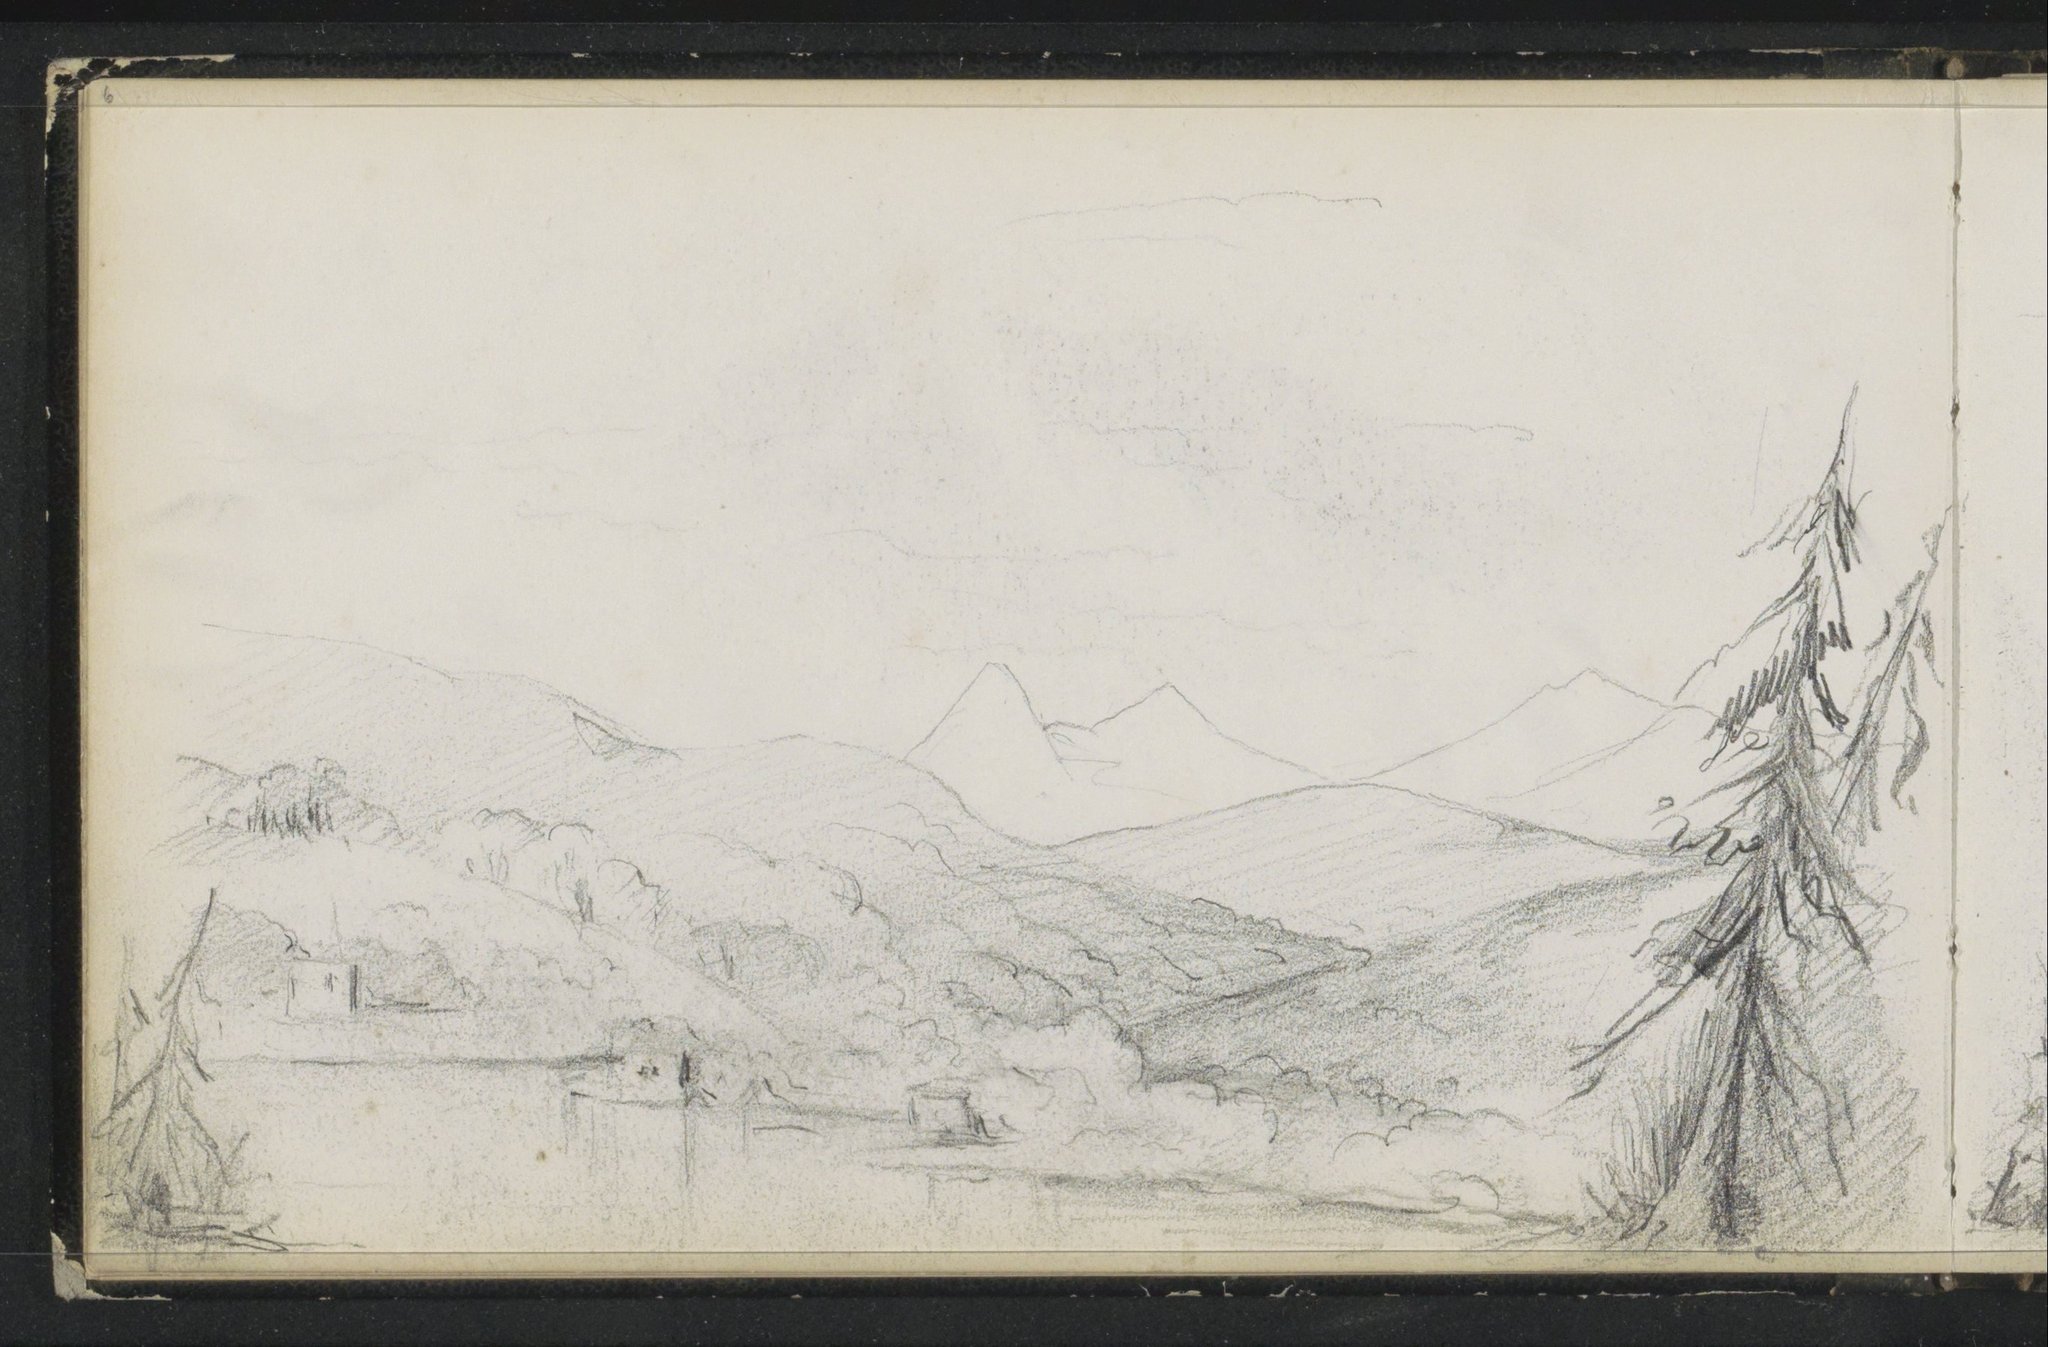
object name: sketchbook leaf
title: Berglandschap met een meer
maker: marius bauer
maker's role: draughtsman, print maker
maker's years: 1867-1932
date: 1812-1880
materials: paper, pencil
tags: city-view, and landscape with man-made constructions, trees: pine, mountains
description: Pagina 6 uit een schetsboek met 34 bladen.